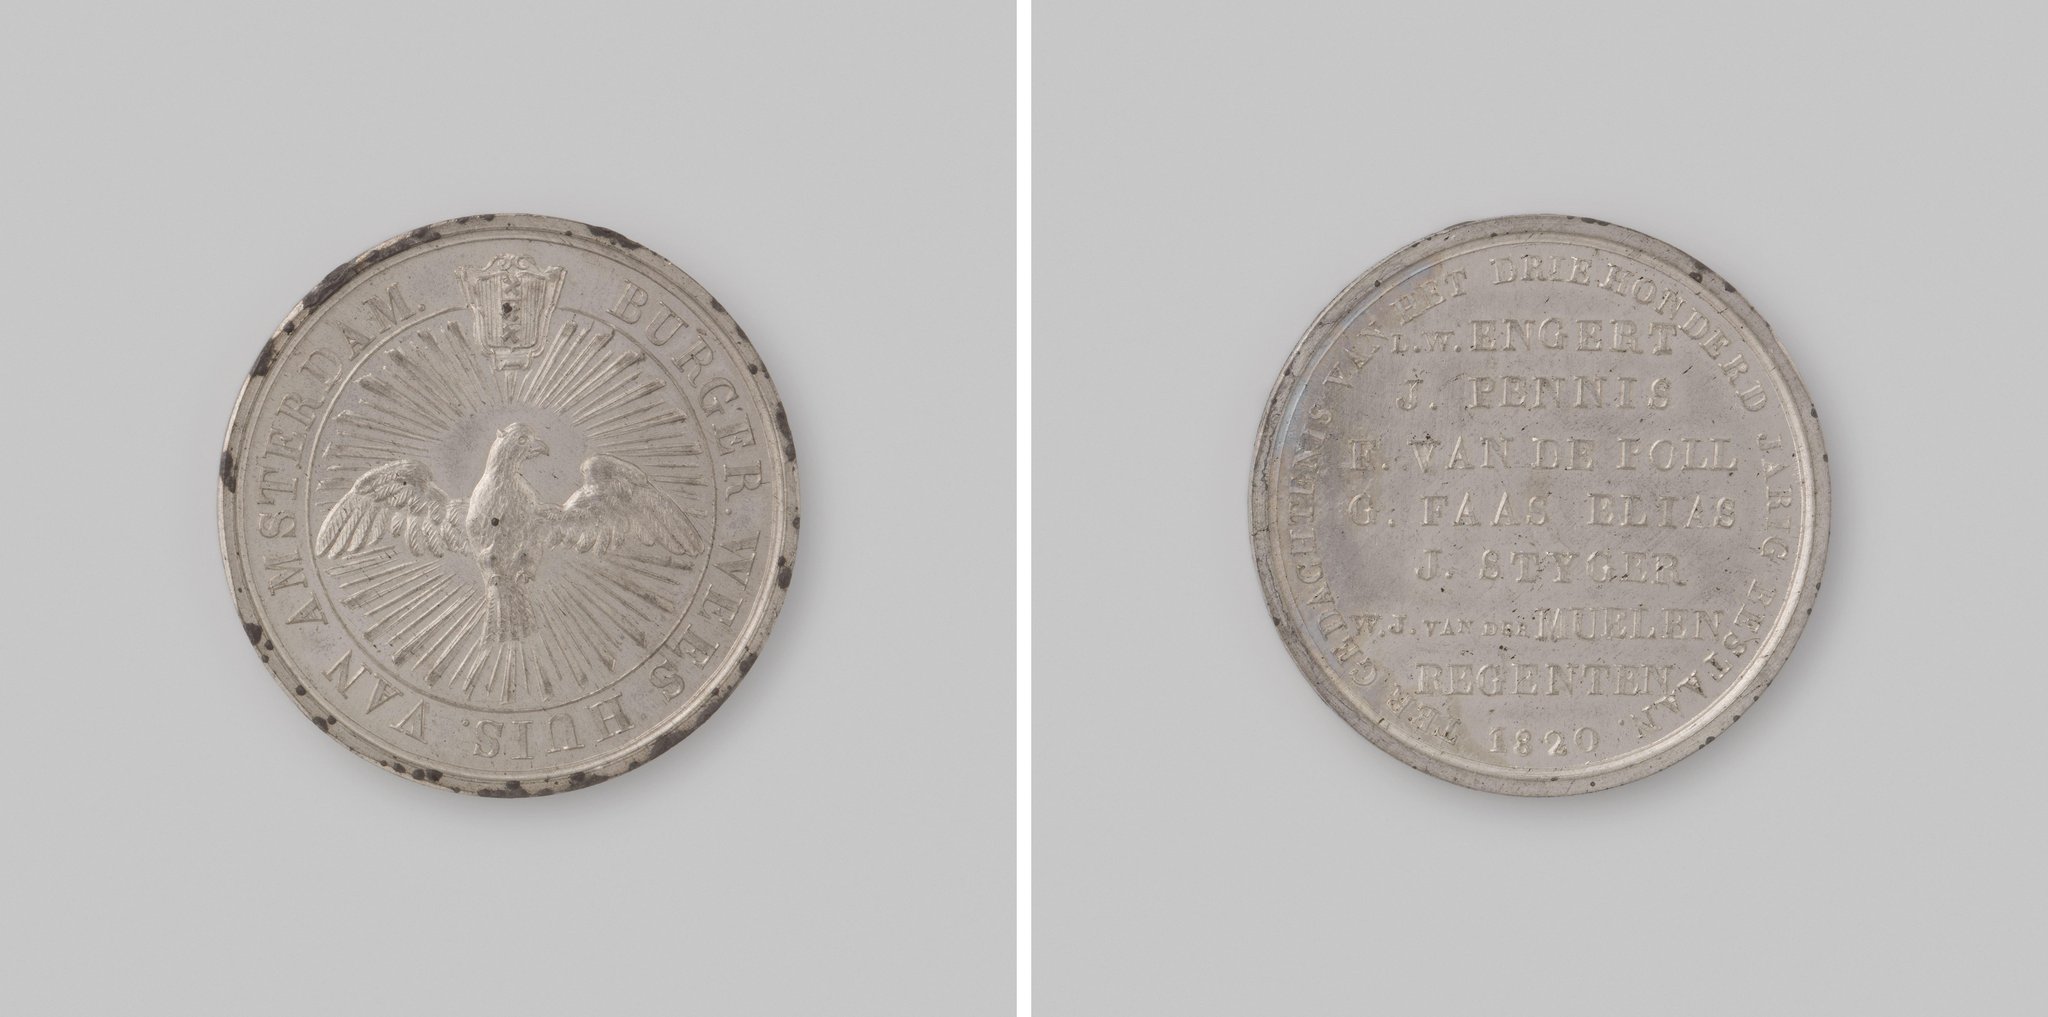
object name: history medal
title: Driehonderdjarig bestaan van het Burgerweeshuis te Amsterdam 1820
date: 1820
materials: tin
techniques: striking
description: Tinnen penning, op de voorzijde een stralende duif onder een Amsterdams wapenschildje, met omschrift, op de keerzijde zeven regels tekst, met omschrift.